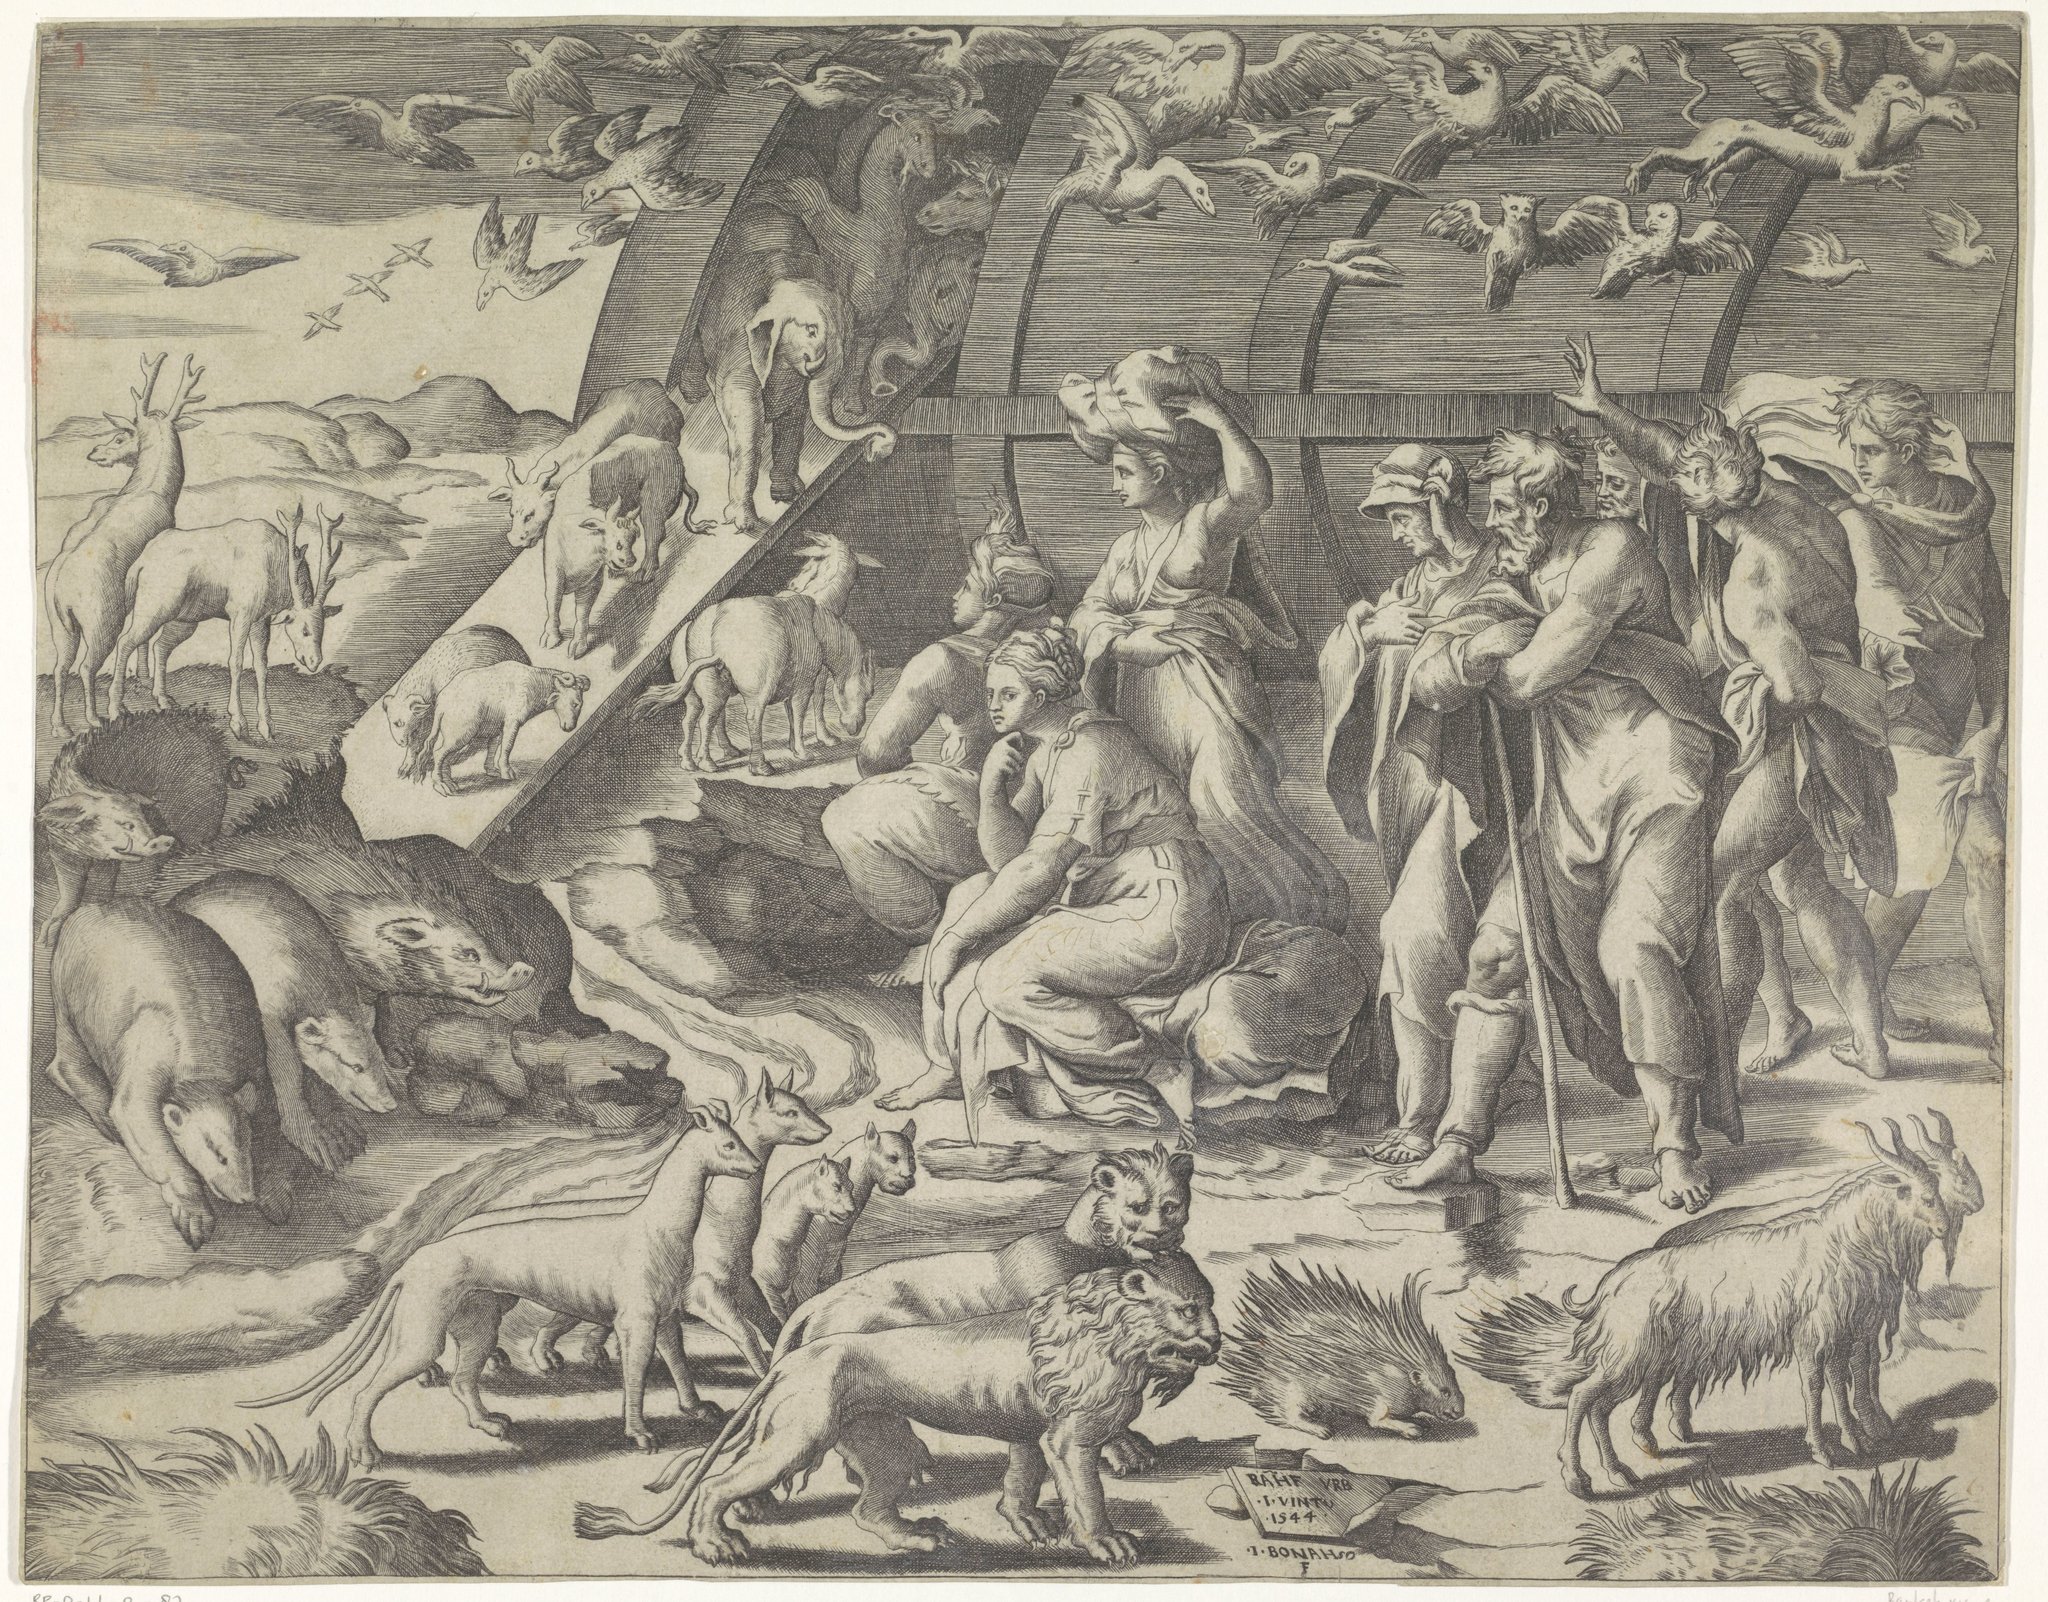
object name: print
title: Noach verlaat de ark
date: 1544-1580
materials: paper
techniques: engraving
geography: italy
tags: the disembarkation ~ story of noah (genesis 8:18 - 9:17)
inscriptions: collector's mark: Lugt 10, collector's mark: ‘Hinloopen’, collector's mark: Lugt 11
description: Noach en zijn familie verlaten samen met de dieren de ark. Op de voorgrond lopen beren, zwijnen, leeuwen, stekelvarkens en geiten. Boven vliegt een grote groep vogels.